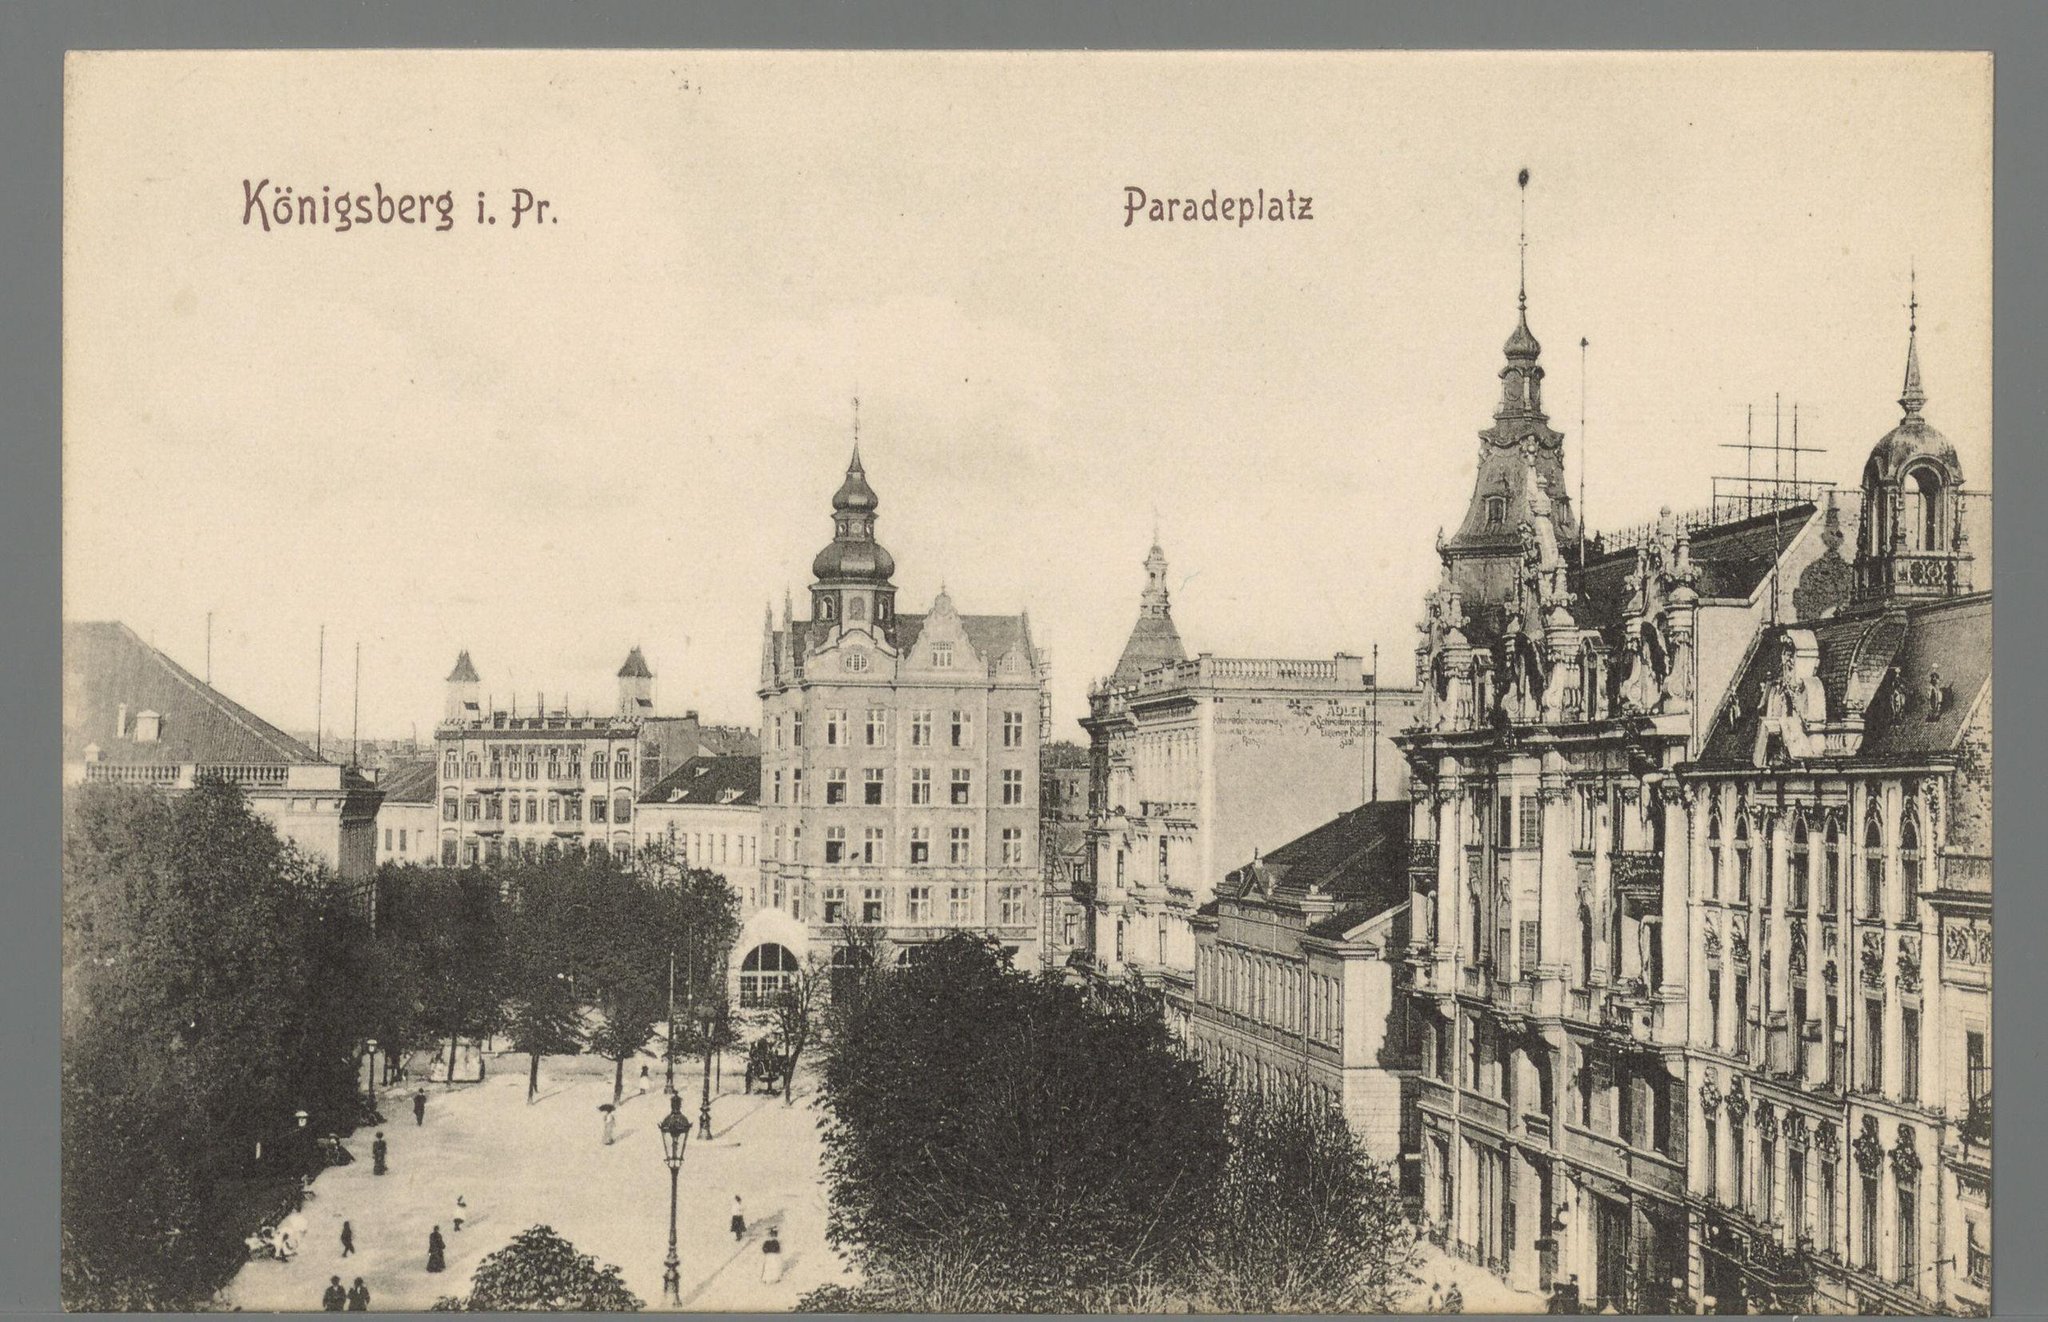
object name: ansichtkaart, prentbriefkaart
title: Königsberg i. Pr. Paradeplatz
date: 1905-1930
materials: cardboard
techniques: photograph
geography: königsberg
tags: square, place, circus, etc.